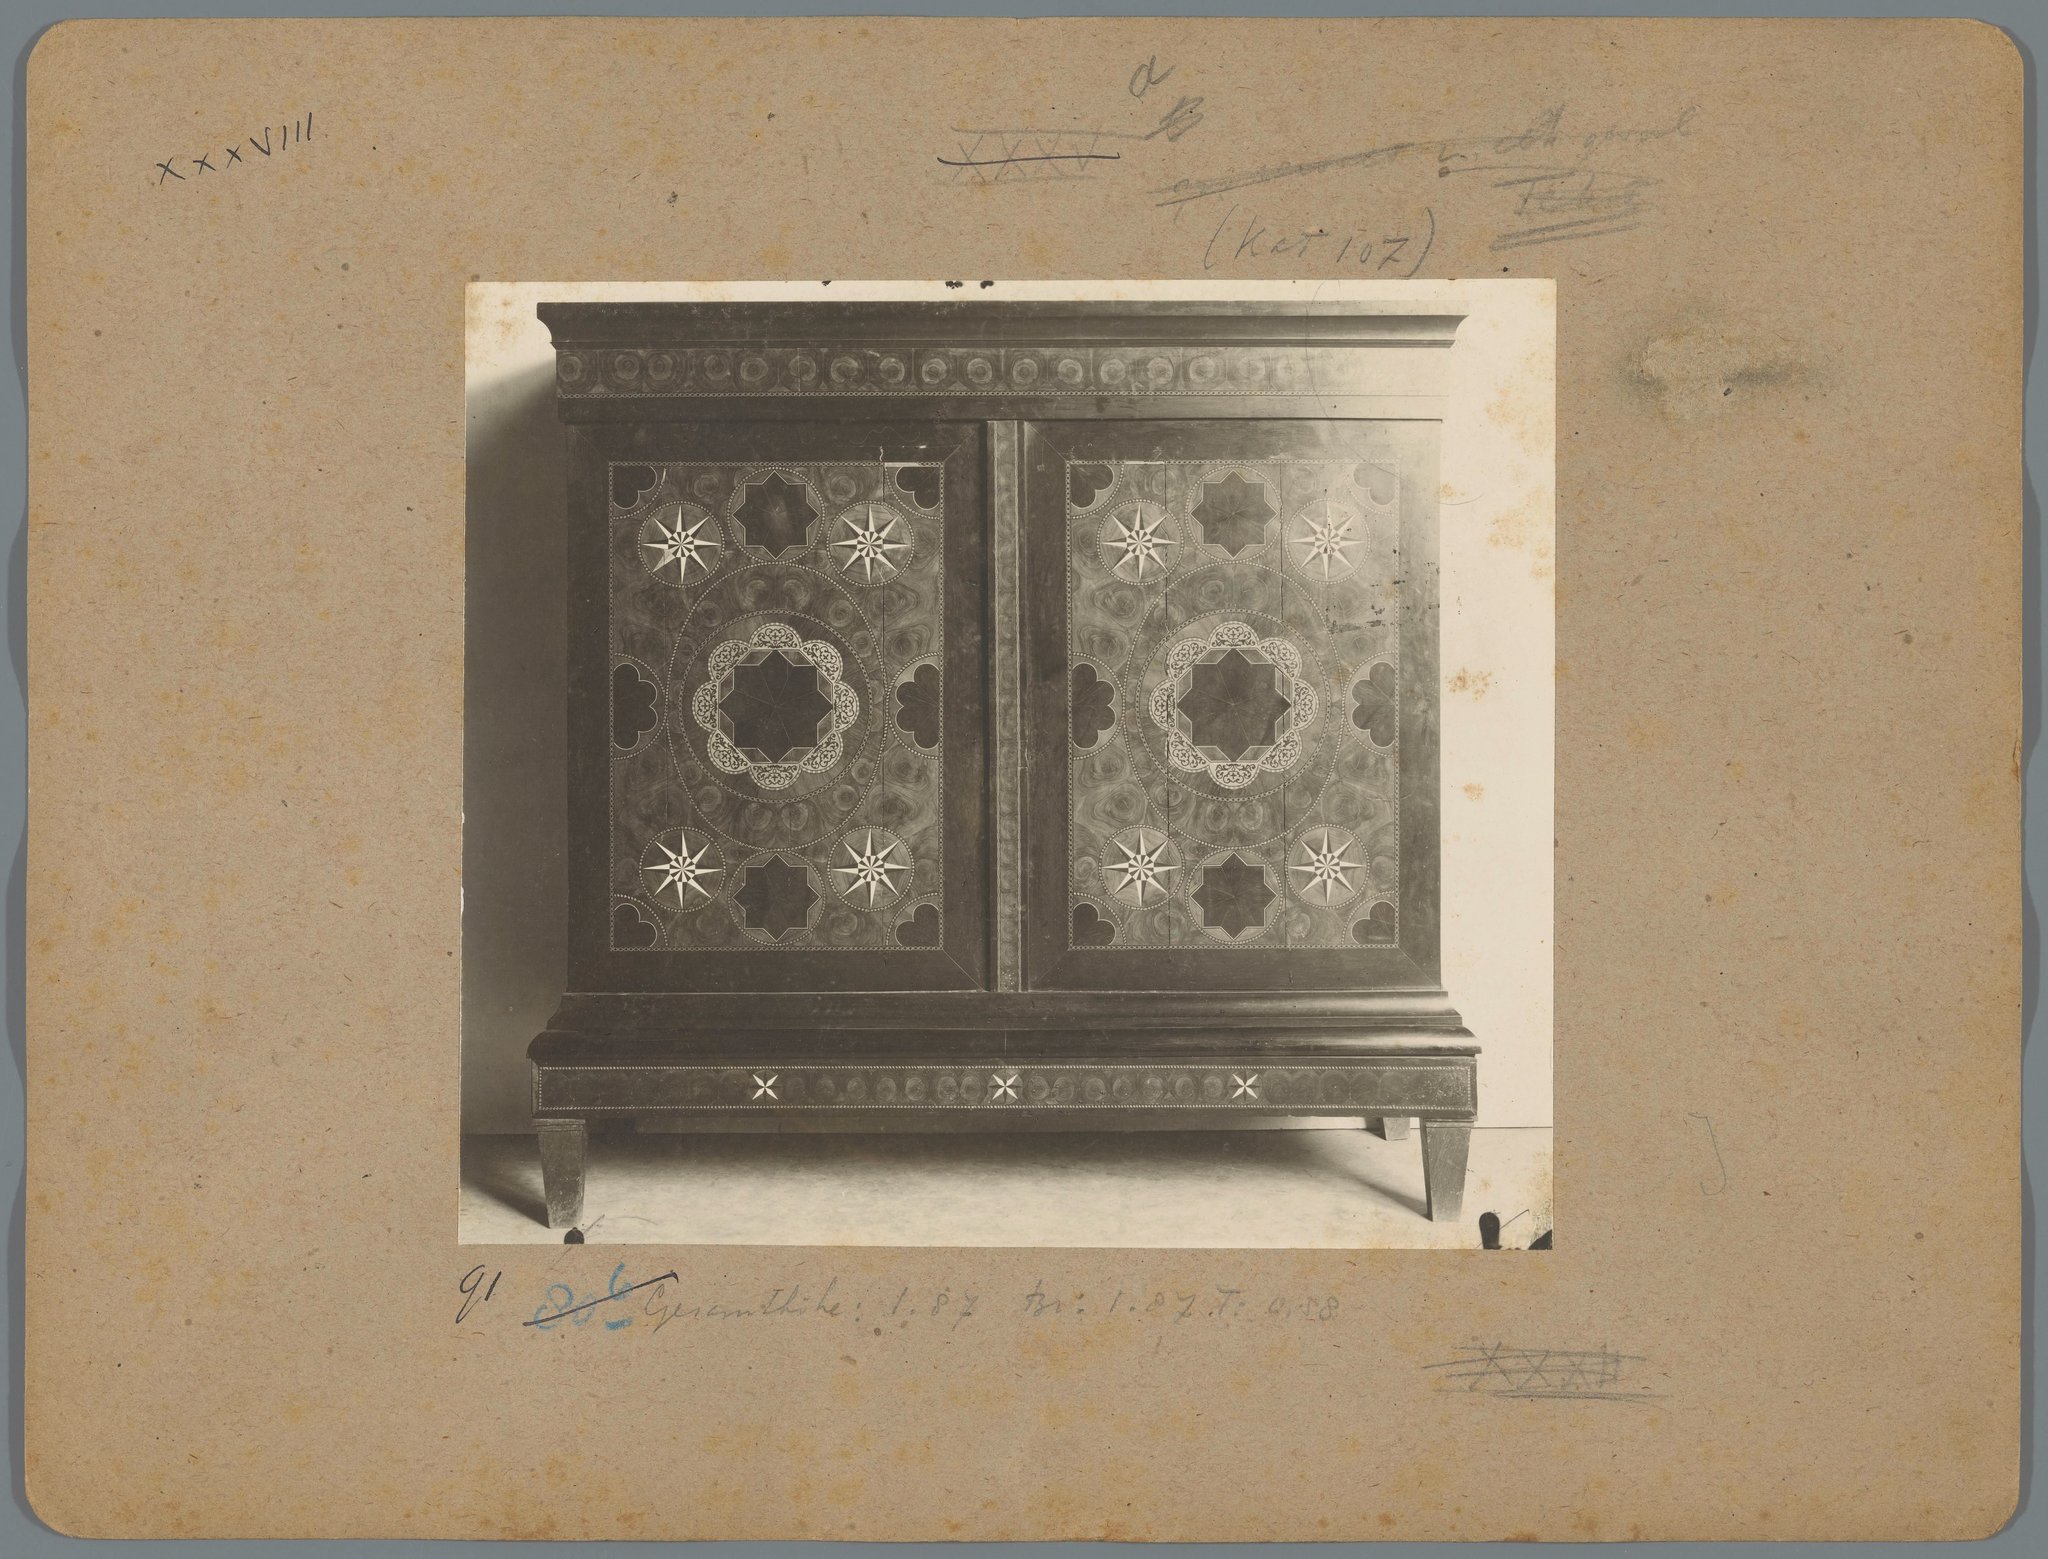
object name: photograph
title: Sterkabinet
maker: Anonymous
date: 1875-1900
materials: cardboard, photographic support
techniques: gelatin silver print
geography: europe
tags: ornament ~ geometric motifs, cupboard, europe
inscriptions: collector's mark: ‘INSTITUUT VOOR KUNST-NIJVERHEIDSONDERWIJS GABRIËL METSUSTRAAT No. 16 AMSTERDAM’, number: ‘(Kat 107)’, number: ‘XXXVIII’, collector's mark: ‘KUNSTNIJVERHEIDSCHOOL QUELLINUS AMSTERDAM FRANS HALSSTRAAT 14.’, number: ‘91’